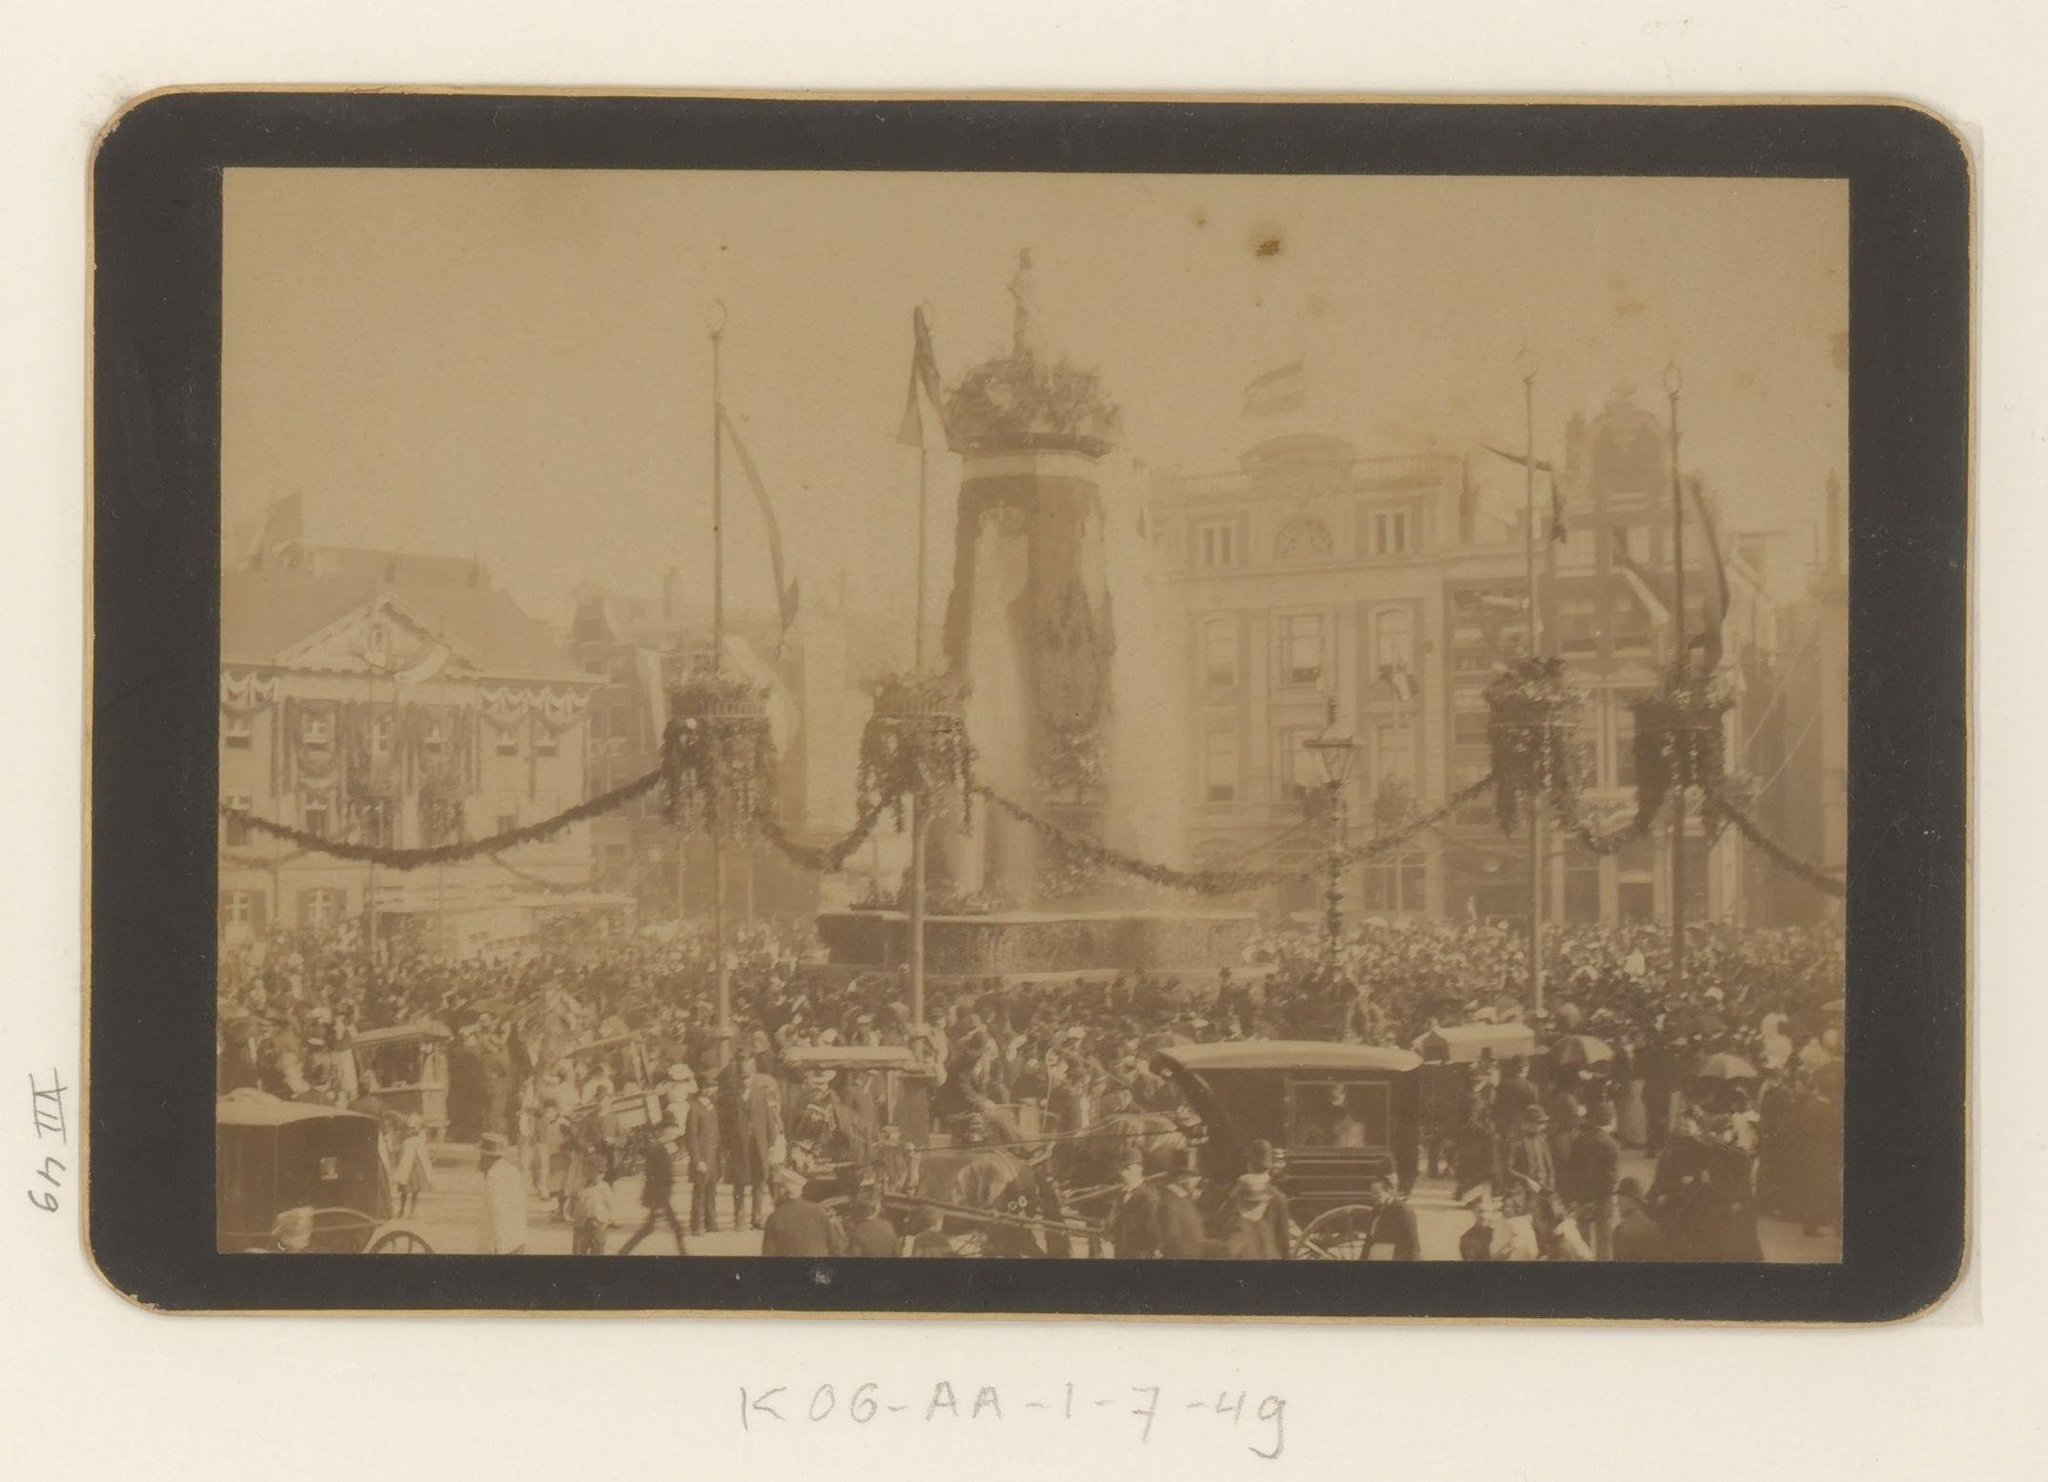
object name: photograph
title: Gezicht op de Dam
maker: Anonymous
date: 1860-1900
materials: cardboard, paper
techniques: albumen print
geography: amsterdam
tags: ceremonial procession, parade, pageant ~ installation of a ruler, square, place, circus, etc., city-view in general; 'veduta'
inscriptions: inscription: ‘Dam met de Keizerfeesten’, collector's mark: ‘7’ Lugt 1641b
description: Onderwerpsrubriek binnen de Atlas Amsterdam: Dam (na 1835).